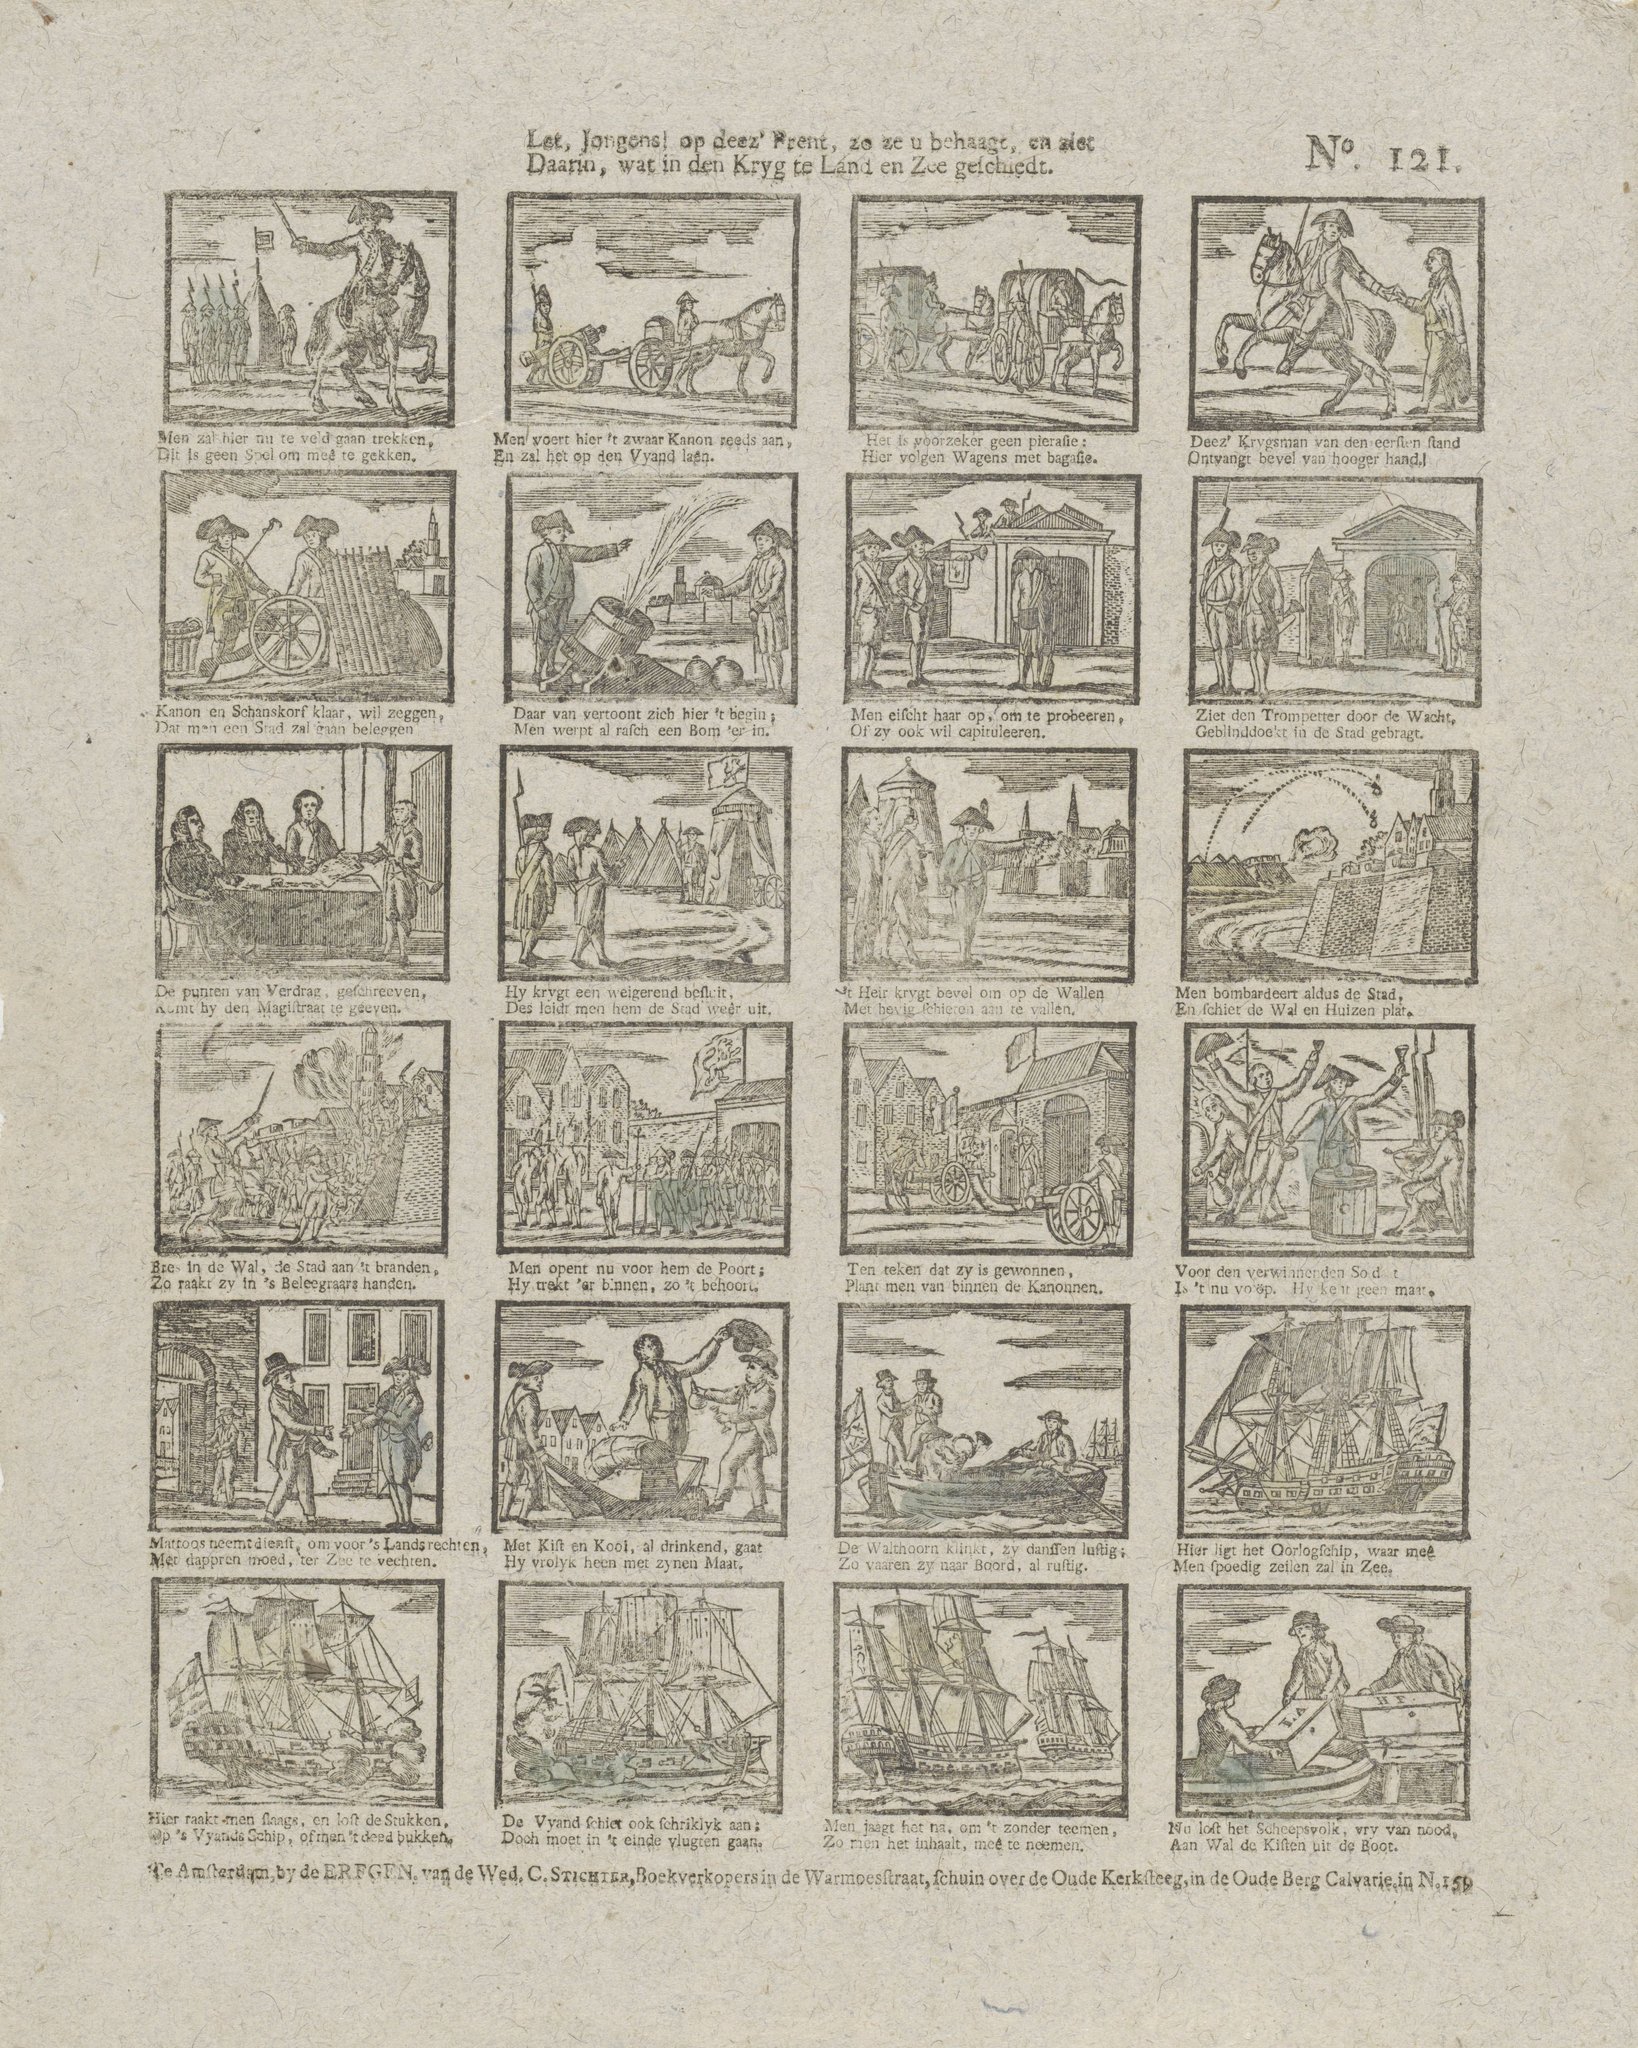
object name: popular print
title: Let, jongens! op deez' prent, zo ze u behaagt, en ziet / Daarin, wat in den kryg te land en zee geschiedt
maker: Anonymous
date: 1715-1813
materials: paper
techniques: colour, letterpress printing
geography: netherlands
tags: military vehicles (+ sailing-ships), firearms: cannon (+ handling of weapons), weapons, the soldier; the soldier's life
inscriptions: collector's mark: Lugt 2760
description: Blad met 24 oorlogstaferelen, met militairen, wapens en schepen. Onder elke afbeelding een tweeregelig vers. Genummerd rechtsboven: No. 121.